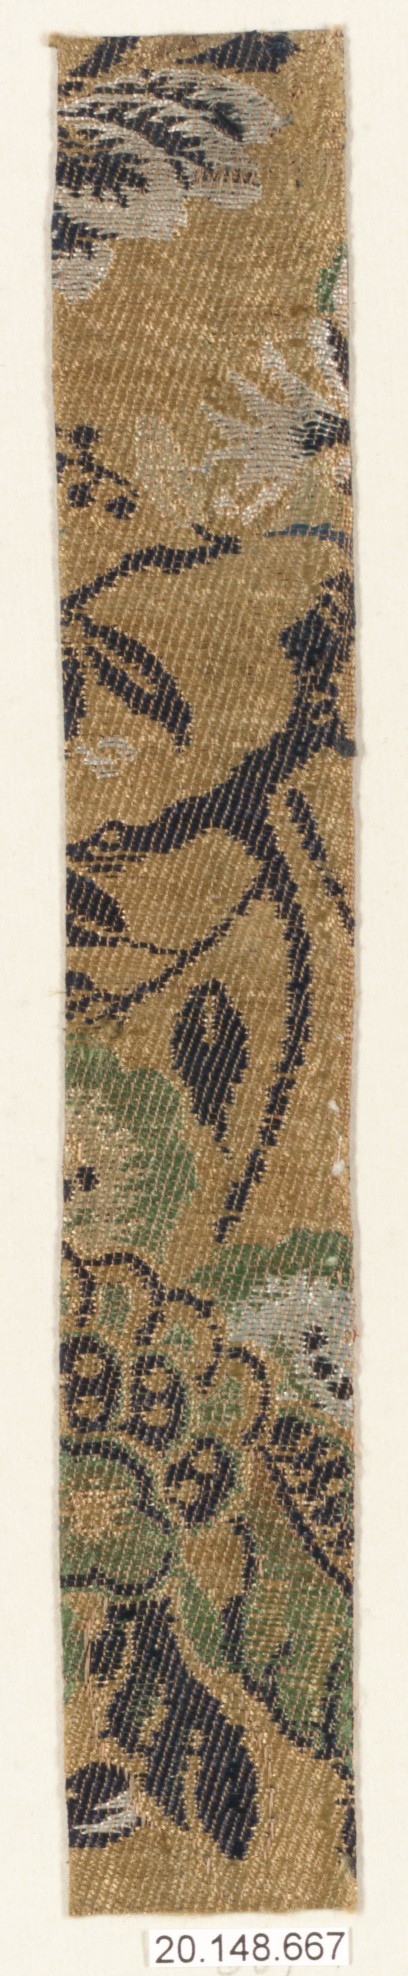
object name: piece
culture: chinese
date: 1701-1800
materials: silk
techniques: compound weave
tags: leaves